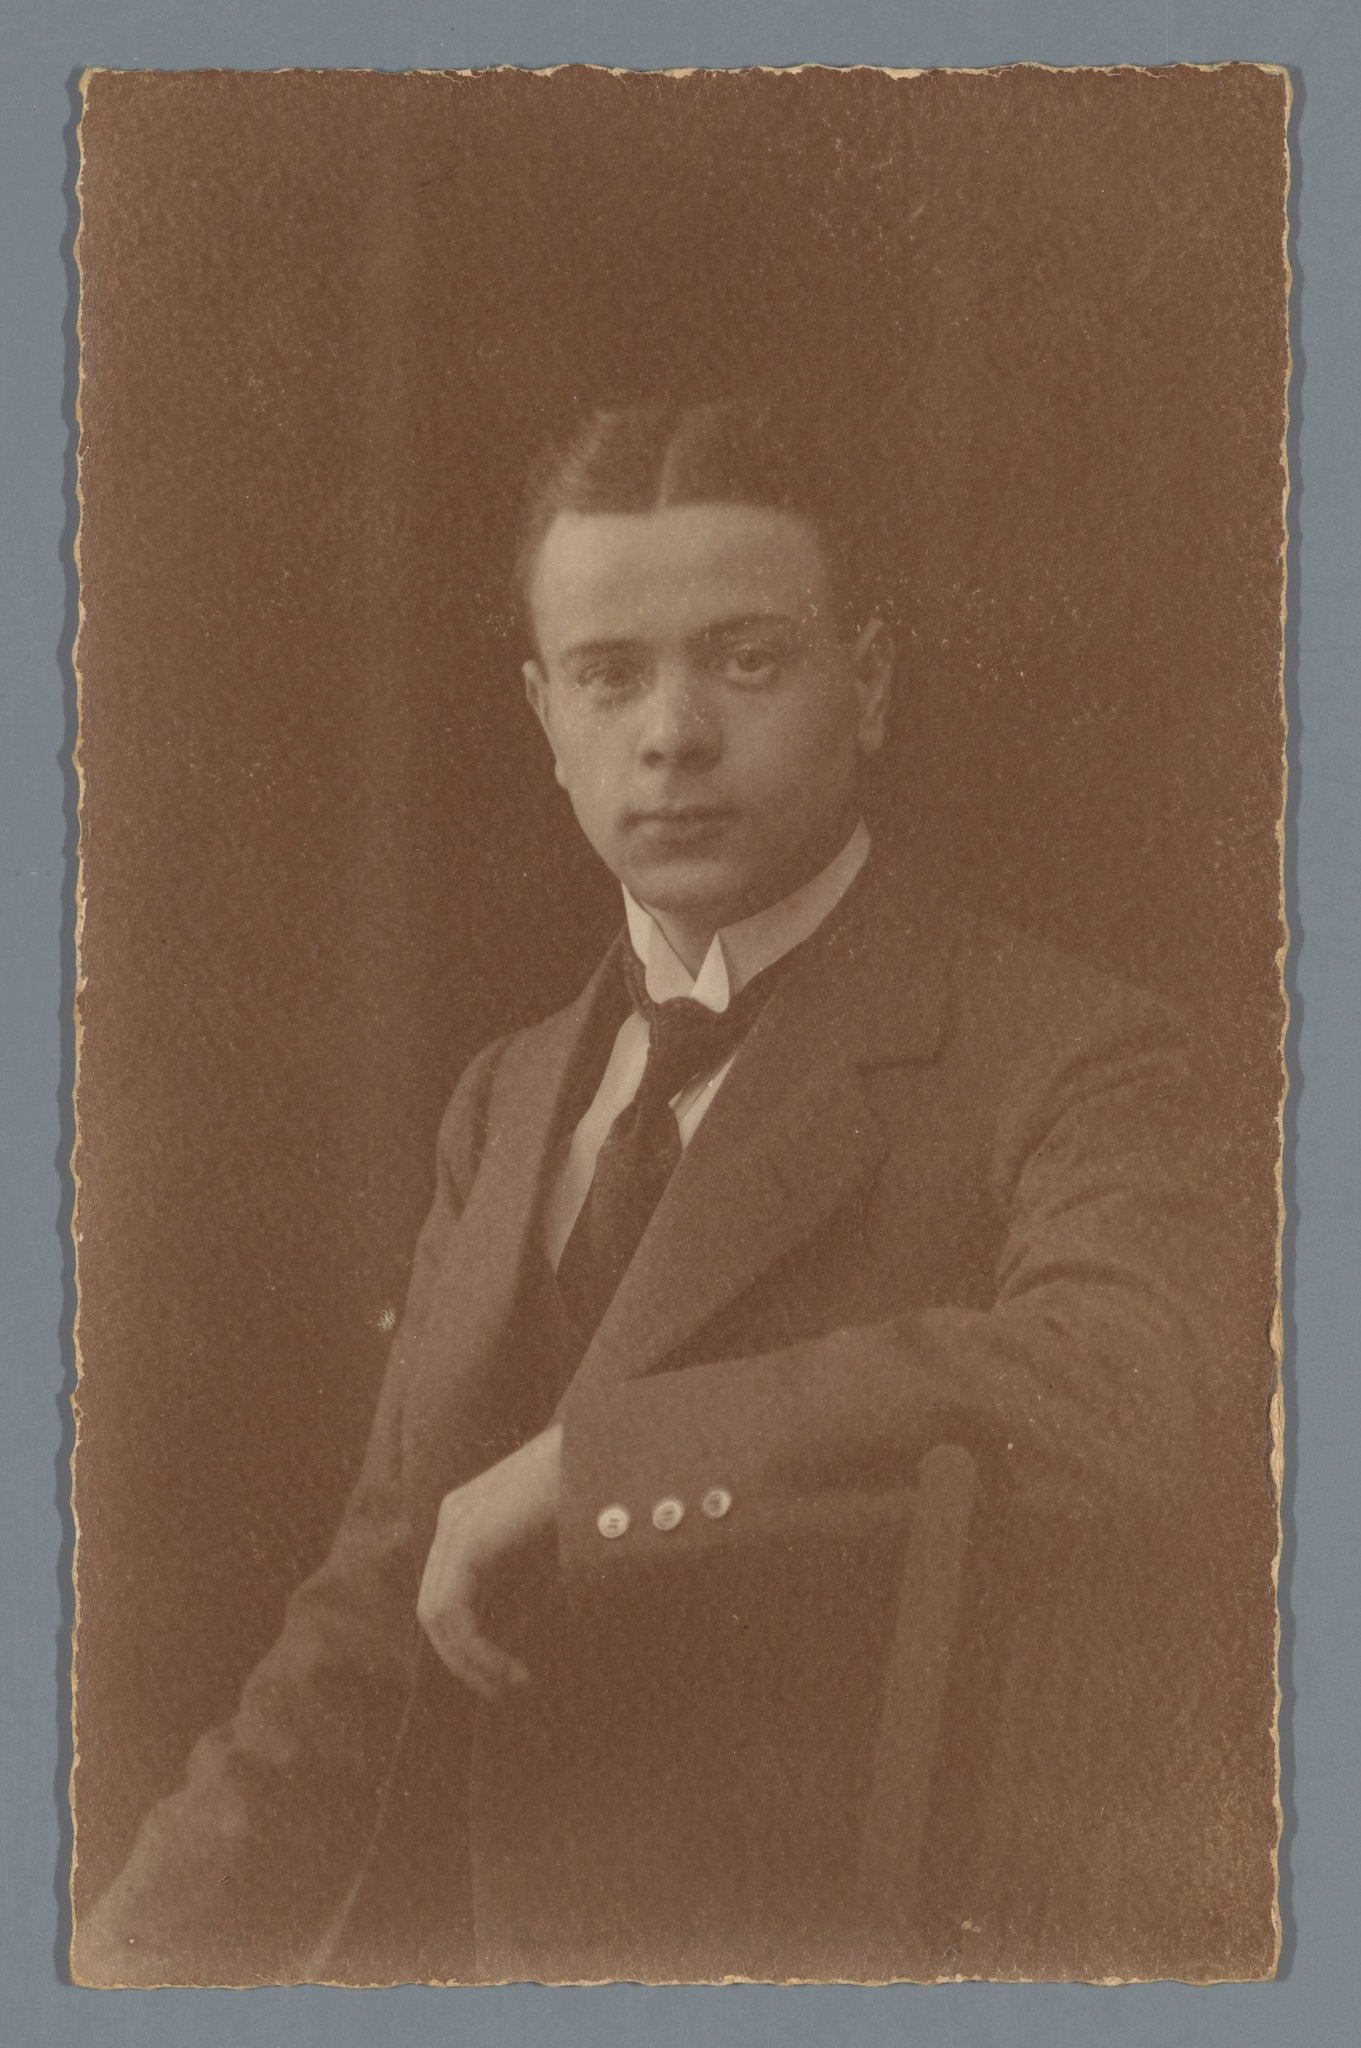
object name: ansichtkaart, prentbriefkaart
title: Portret van een onbekende man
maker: Anonymous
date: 1907-1920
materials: photographic support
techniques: gelatin silver print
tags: adult man